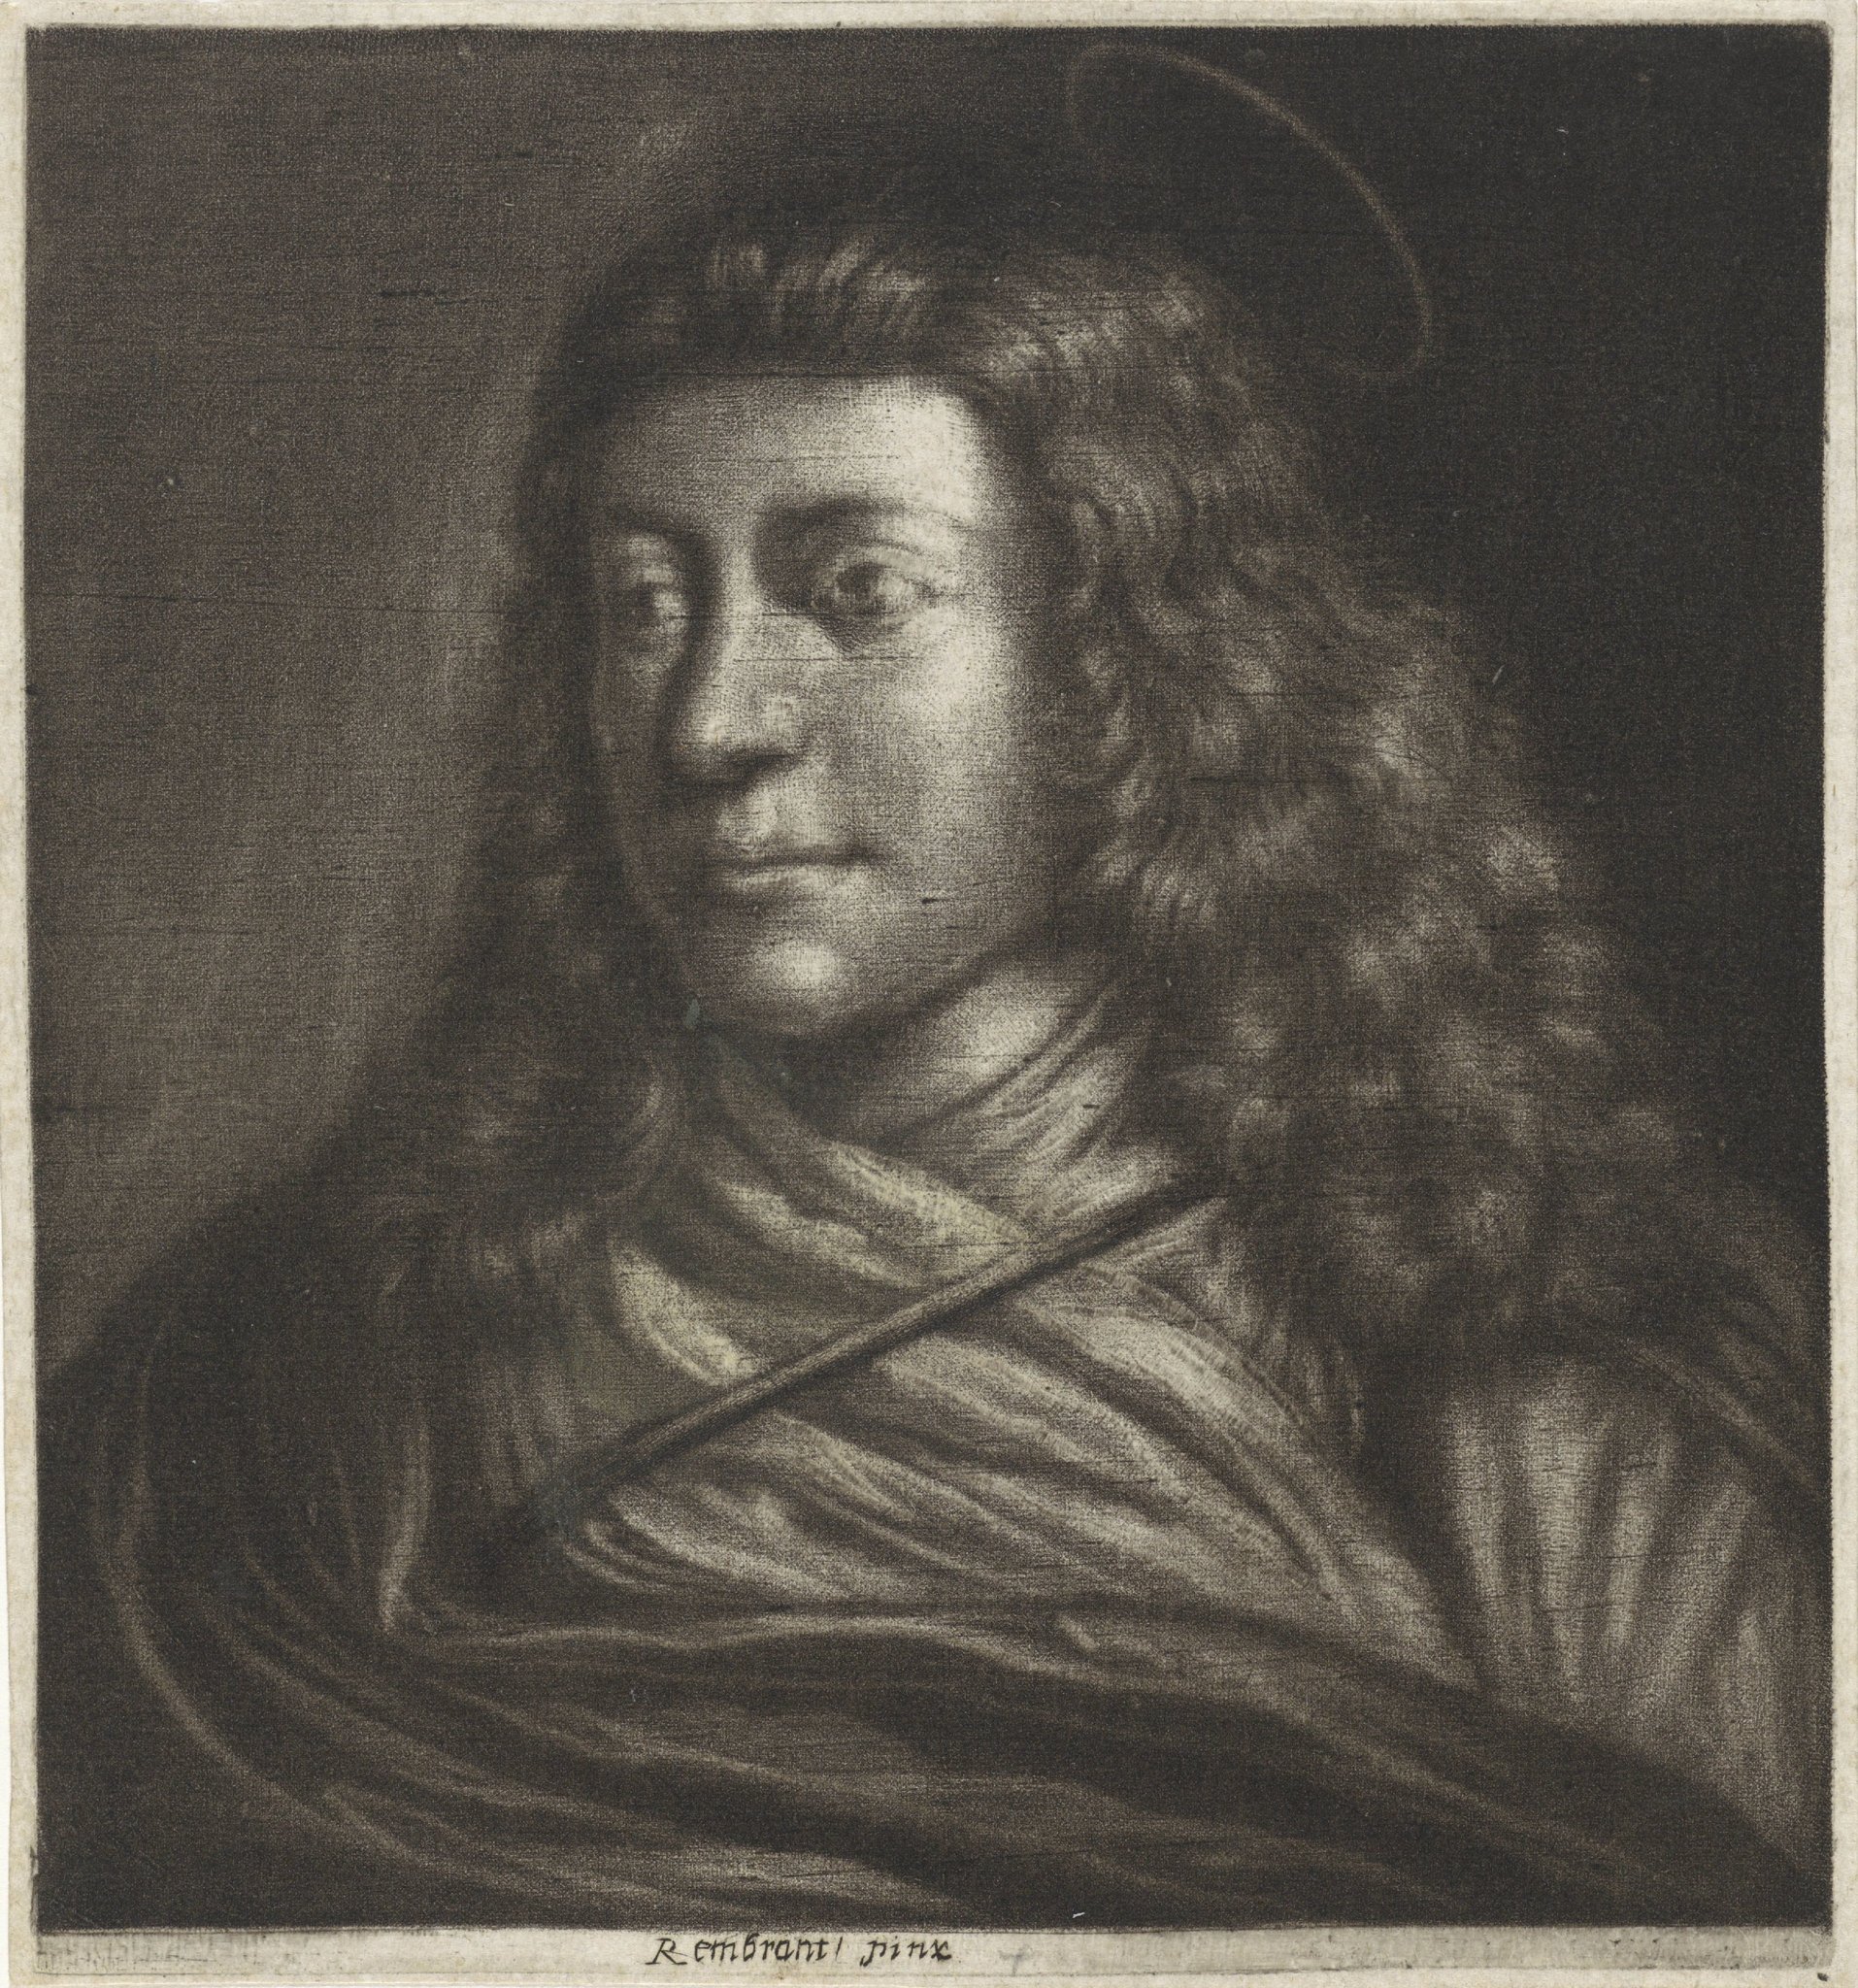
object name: print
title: Apostel, mogelijk de H. Johannes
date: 1655-1700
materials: paper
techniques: mezzotint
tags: the apostle john the evangelist; possible attributes: book, cauldron, chalice with snake, eagle, palm, scroll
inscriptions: collector's mark: Lugt 2228